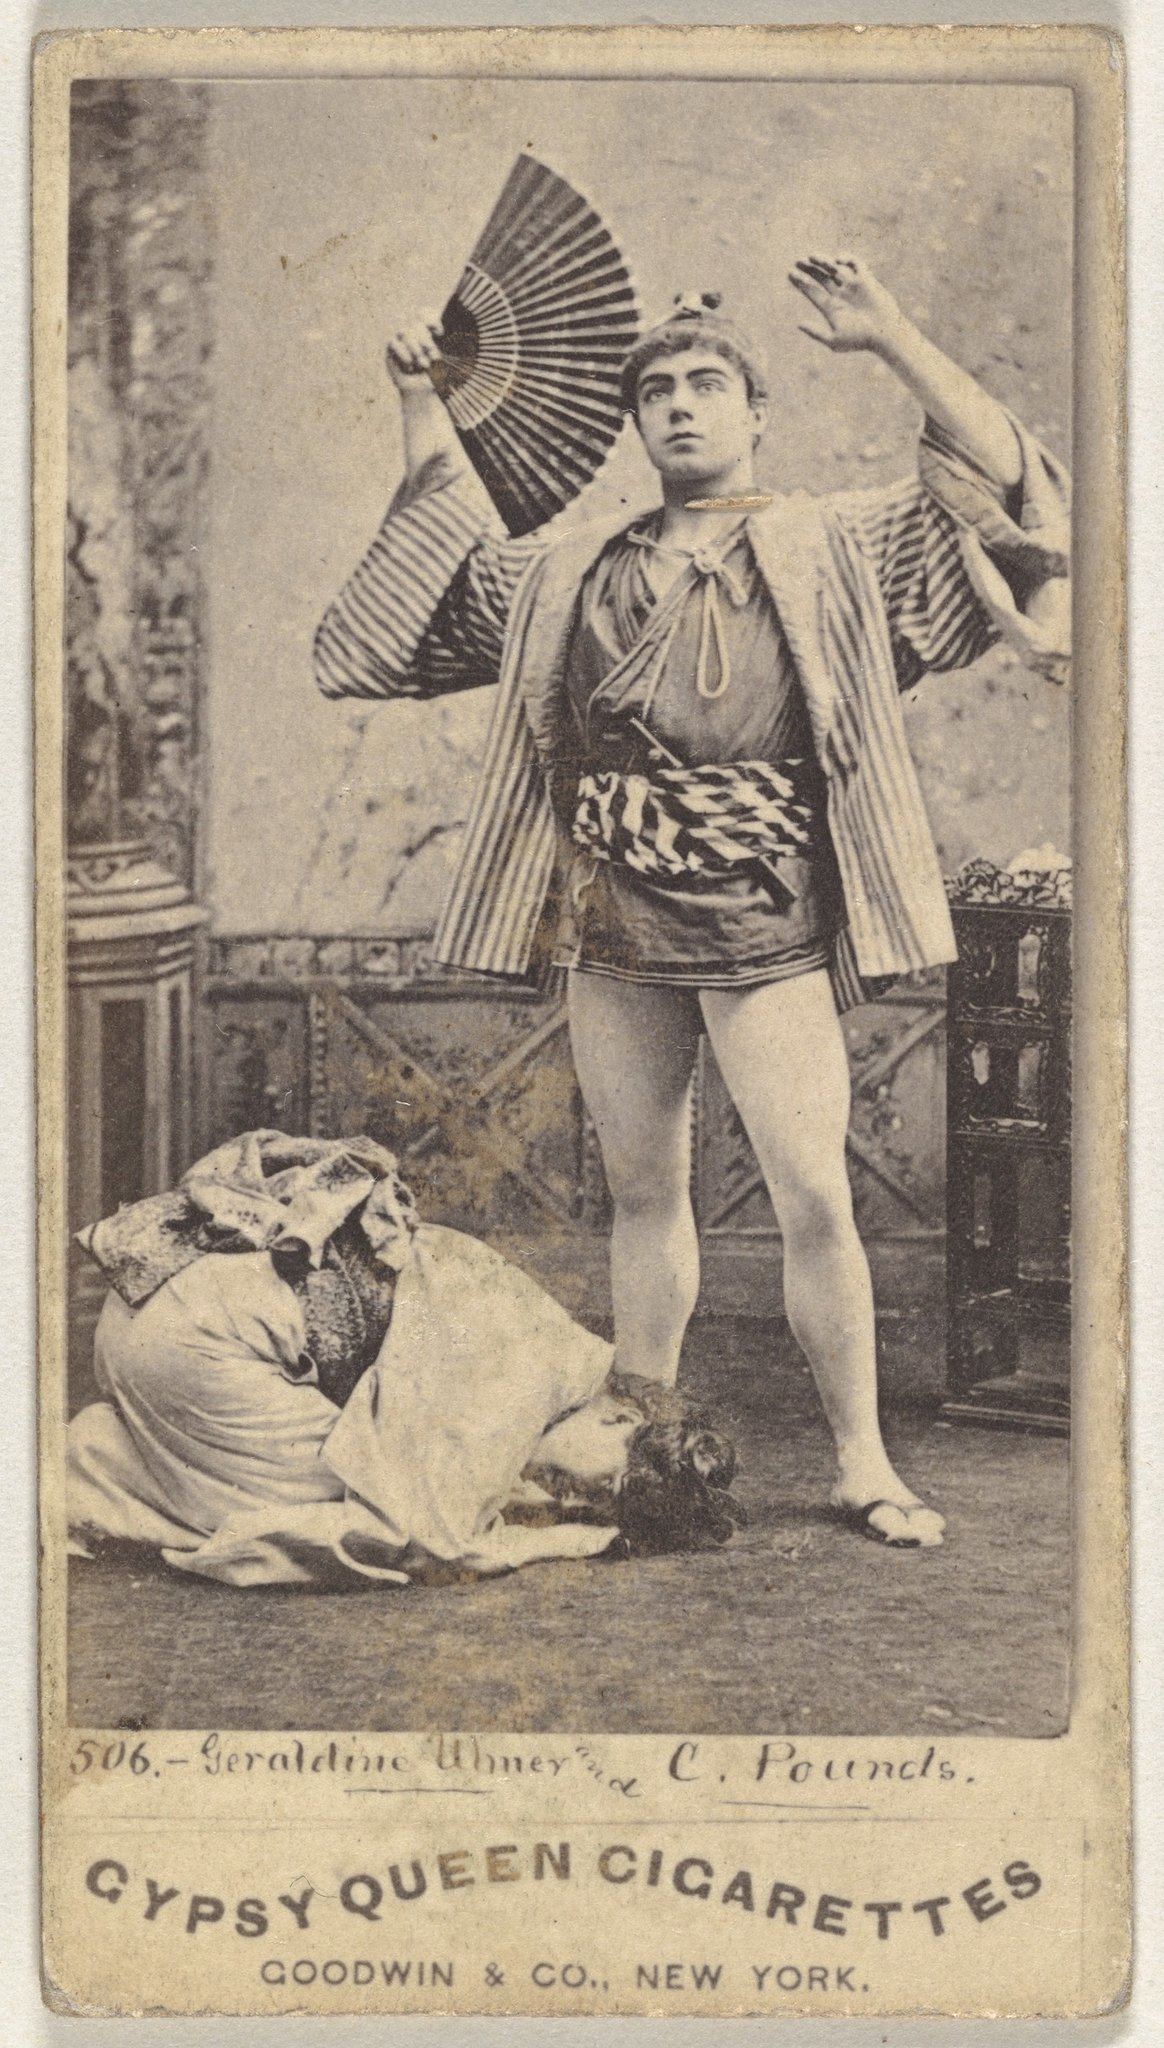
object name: photograph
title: Geraldine Uhner and C. Pounds, from the Actors and Actresses series (N171) for Gypsy Queen Cigarettes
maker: goodwin & company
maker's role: publisher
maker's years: 1850-1950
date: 1886-1890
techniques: albumen silver print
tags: fans,men,women,actors,actresses